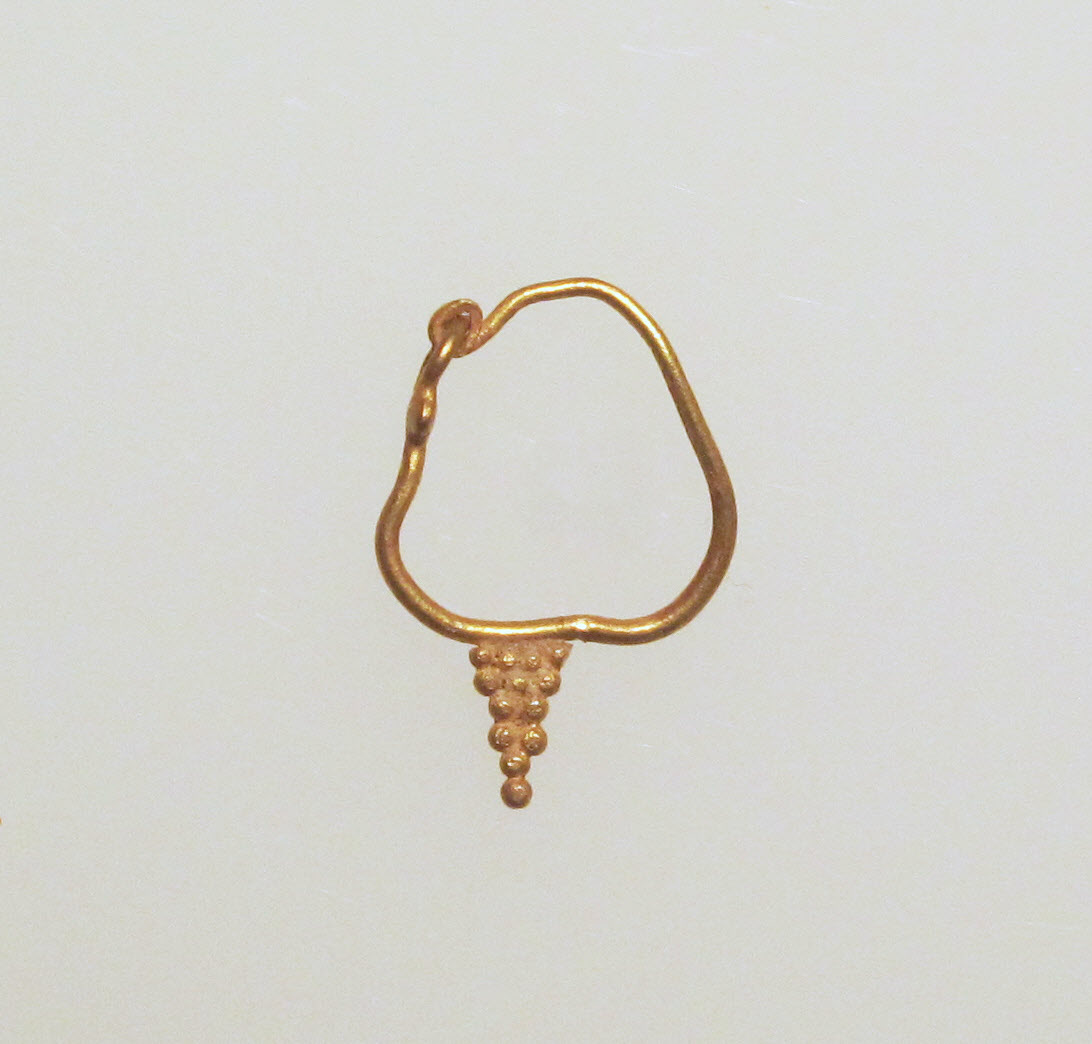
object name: earring with pyramid of ball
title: Earring with pyramid of balls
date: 7000 BCE-330 CE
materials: gold